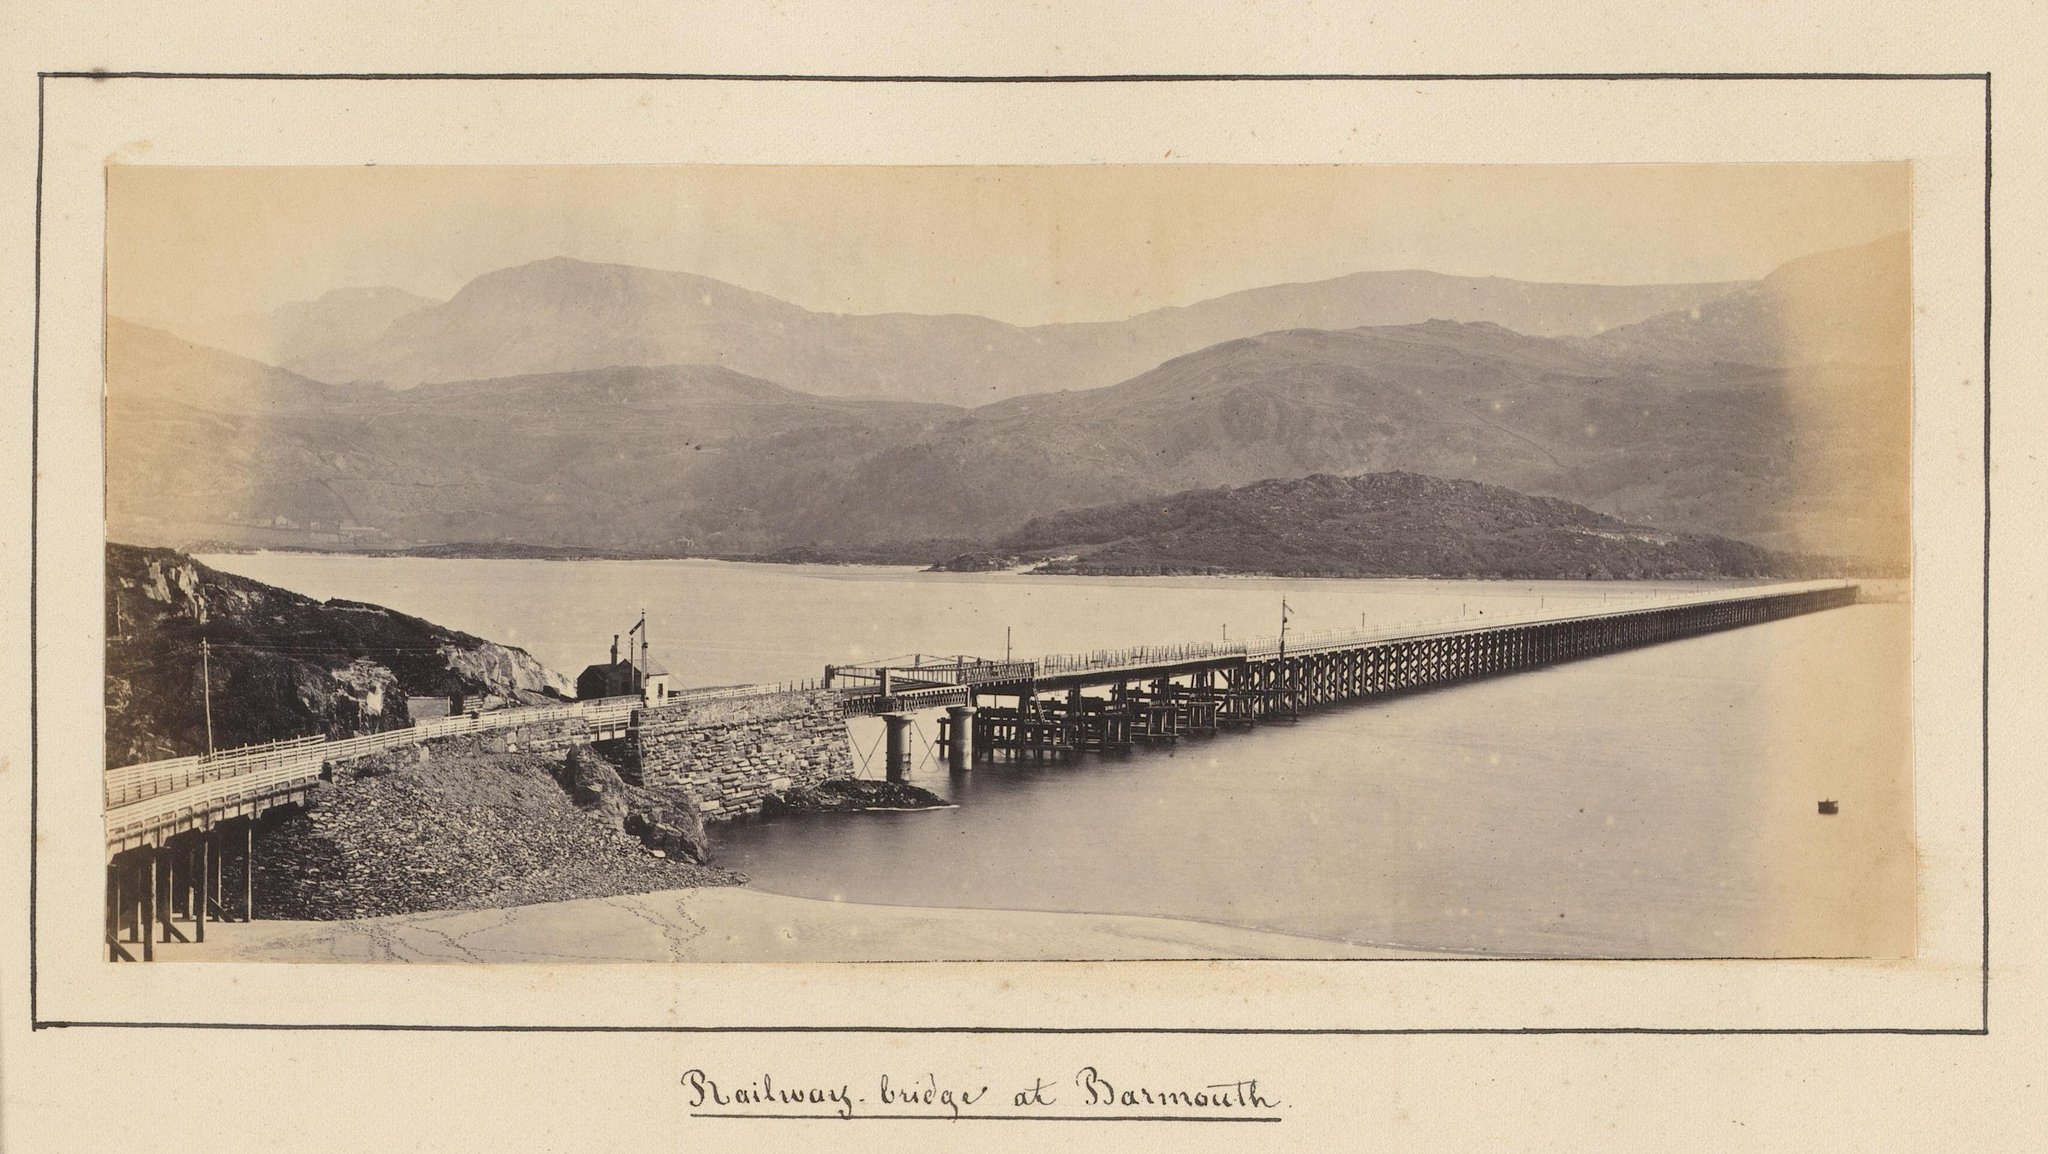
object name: album leaf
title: Spoorbrug bij Barmouth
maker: Anonymous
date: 1867-1890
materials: paper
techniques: albumen print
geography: barmouth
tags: river mouth, estuary, bridge